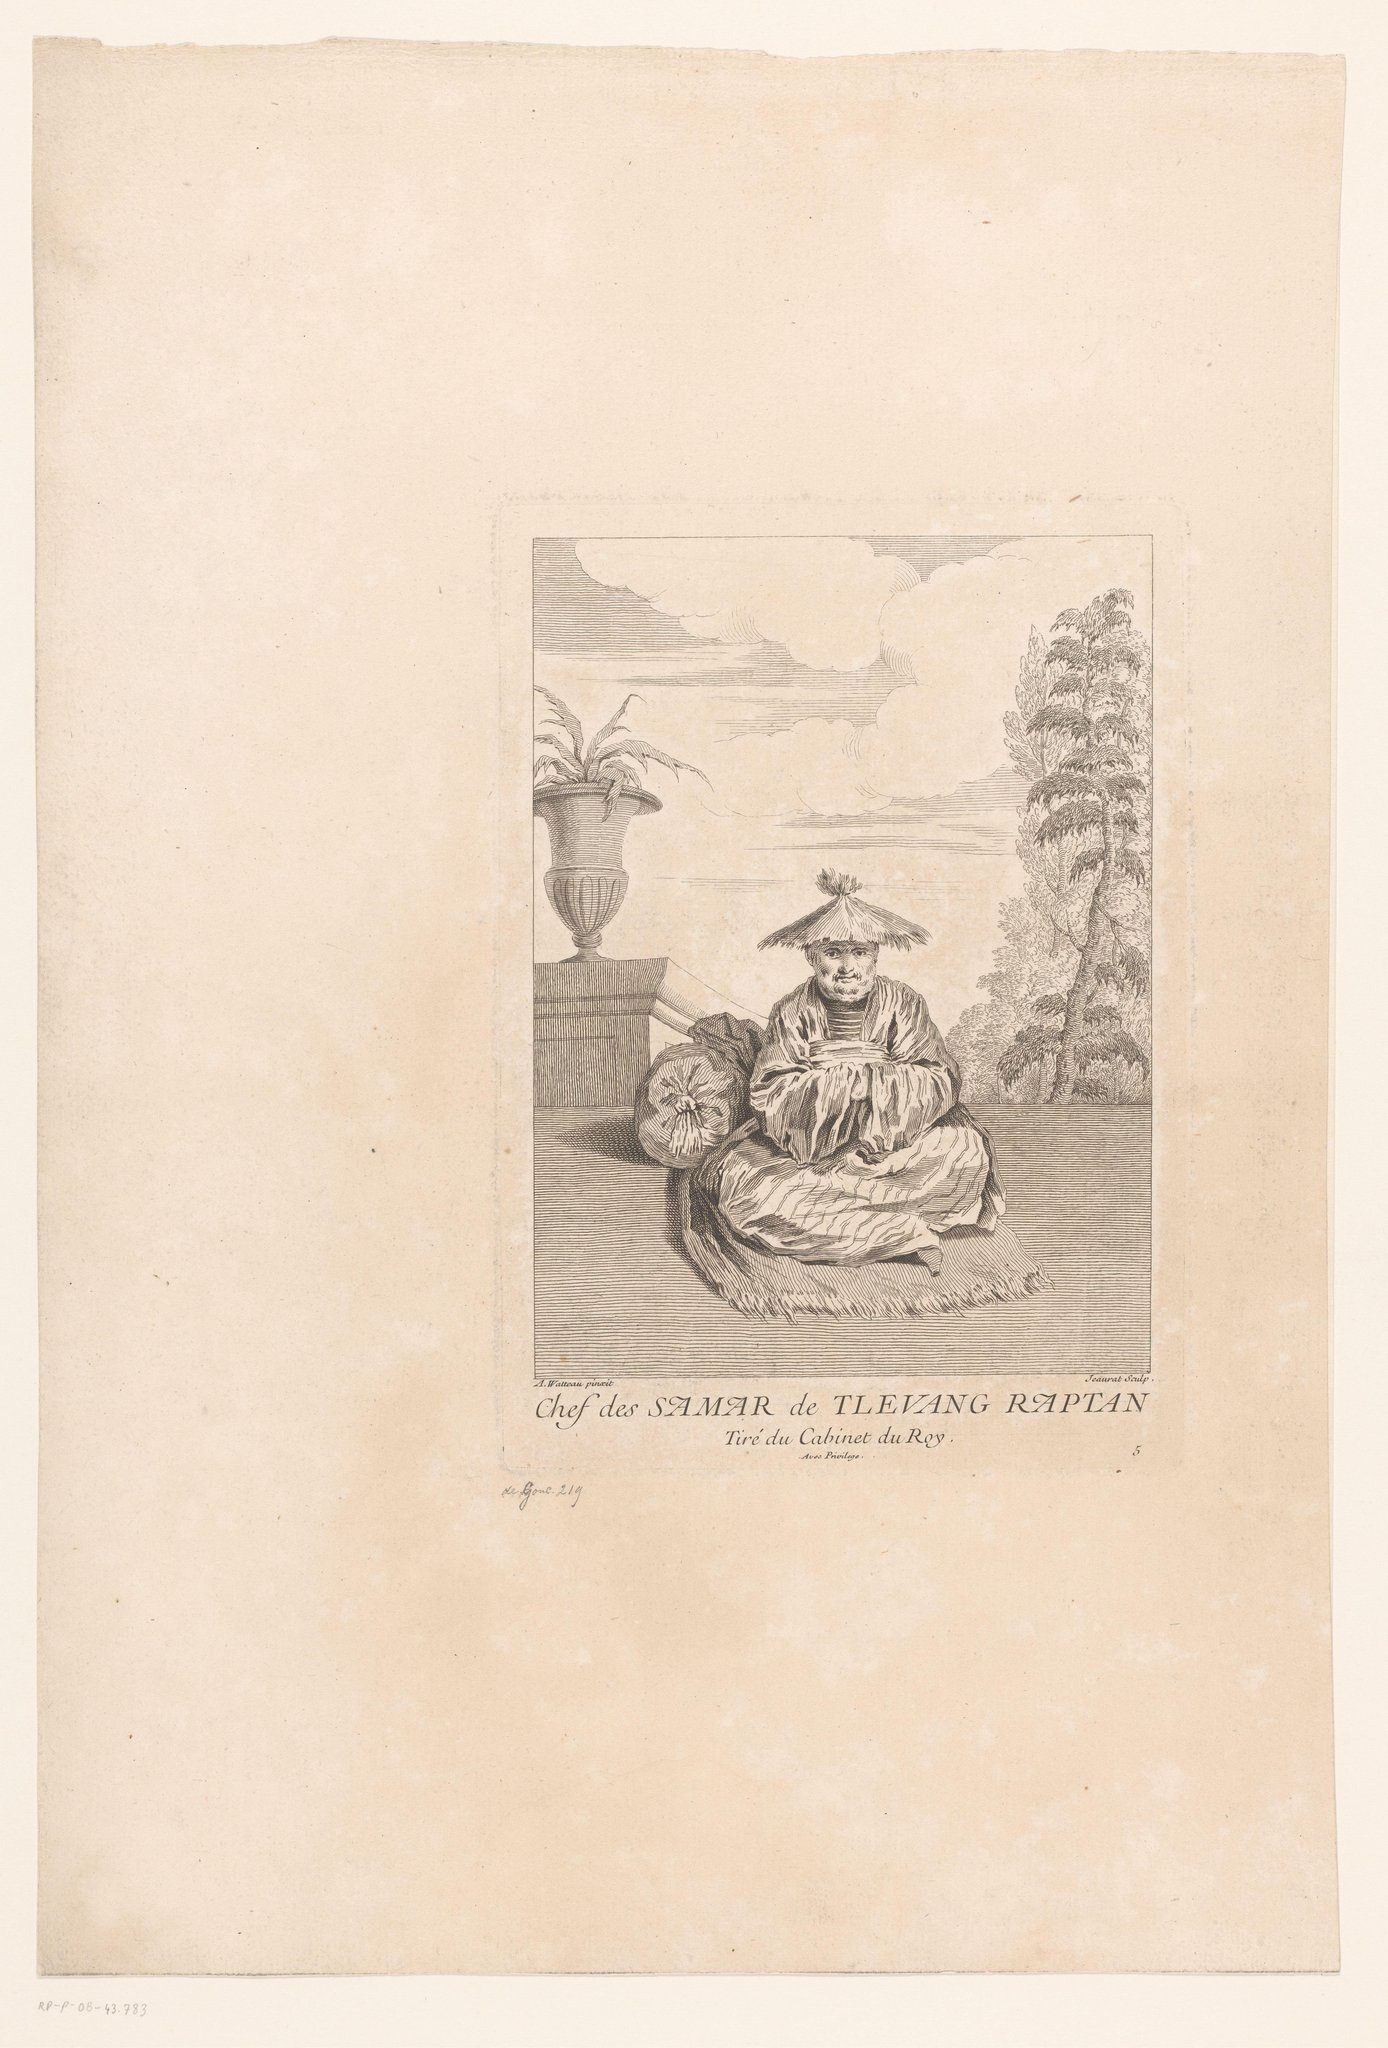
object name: print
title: Chinese man in kleermakerszit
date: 1731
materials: paper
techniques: etching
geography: france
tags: chinese (+ costume)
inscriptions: collector's mark: Lugt 2228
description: Plaat 254 uit 'L'Oeuvre d'Antoine Watteau', een serie van 271 platen, inclusief twee titelprenten, naar schilderijen door Watteau en verzameld door Jean de Jullienne. Maakt ook deel uit van een serie van 30 prenten over Chinese kostuums en van een subserie van 12 prenten gemaakt door Jeaurat.